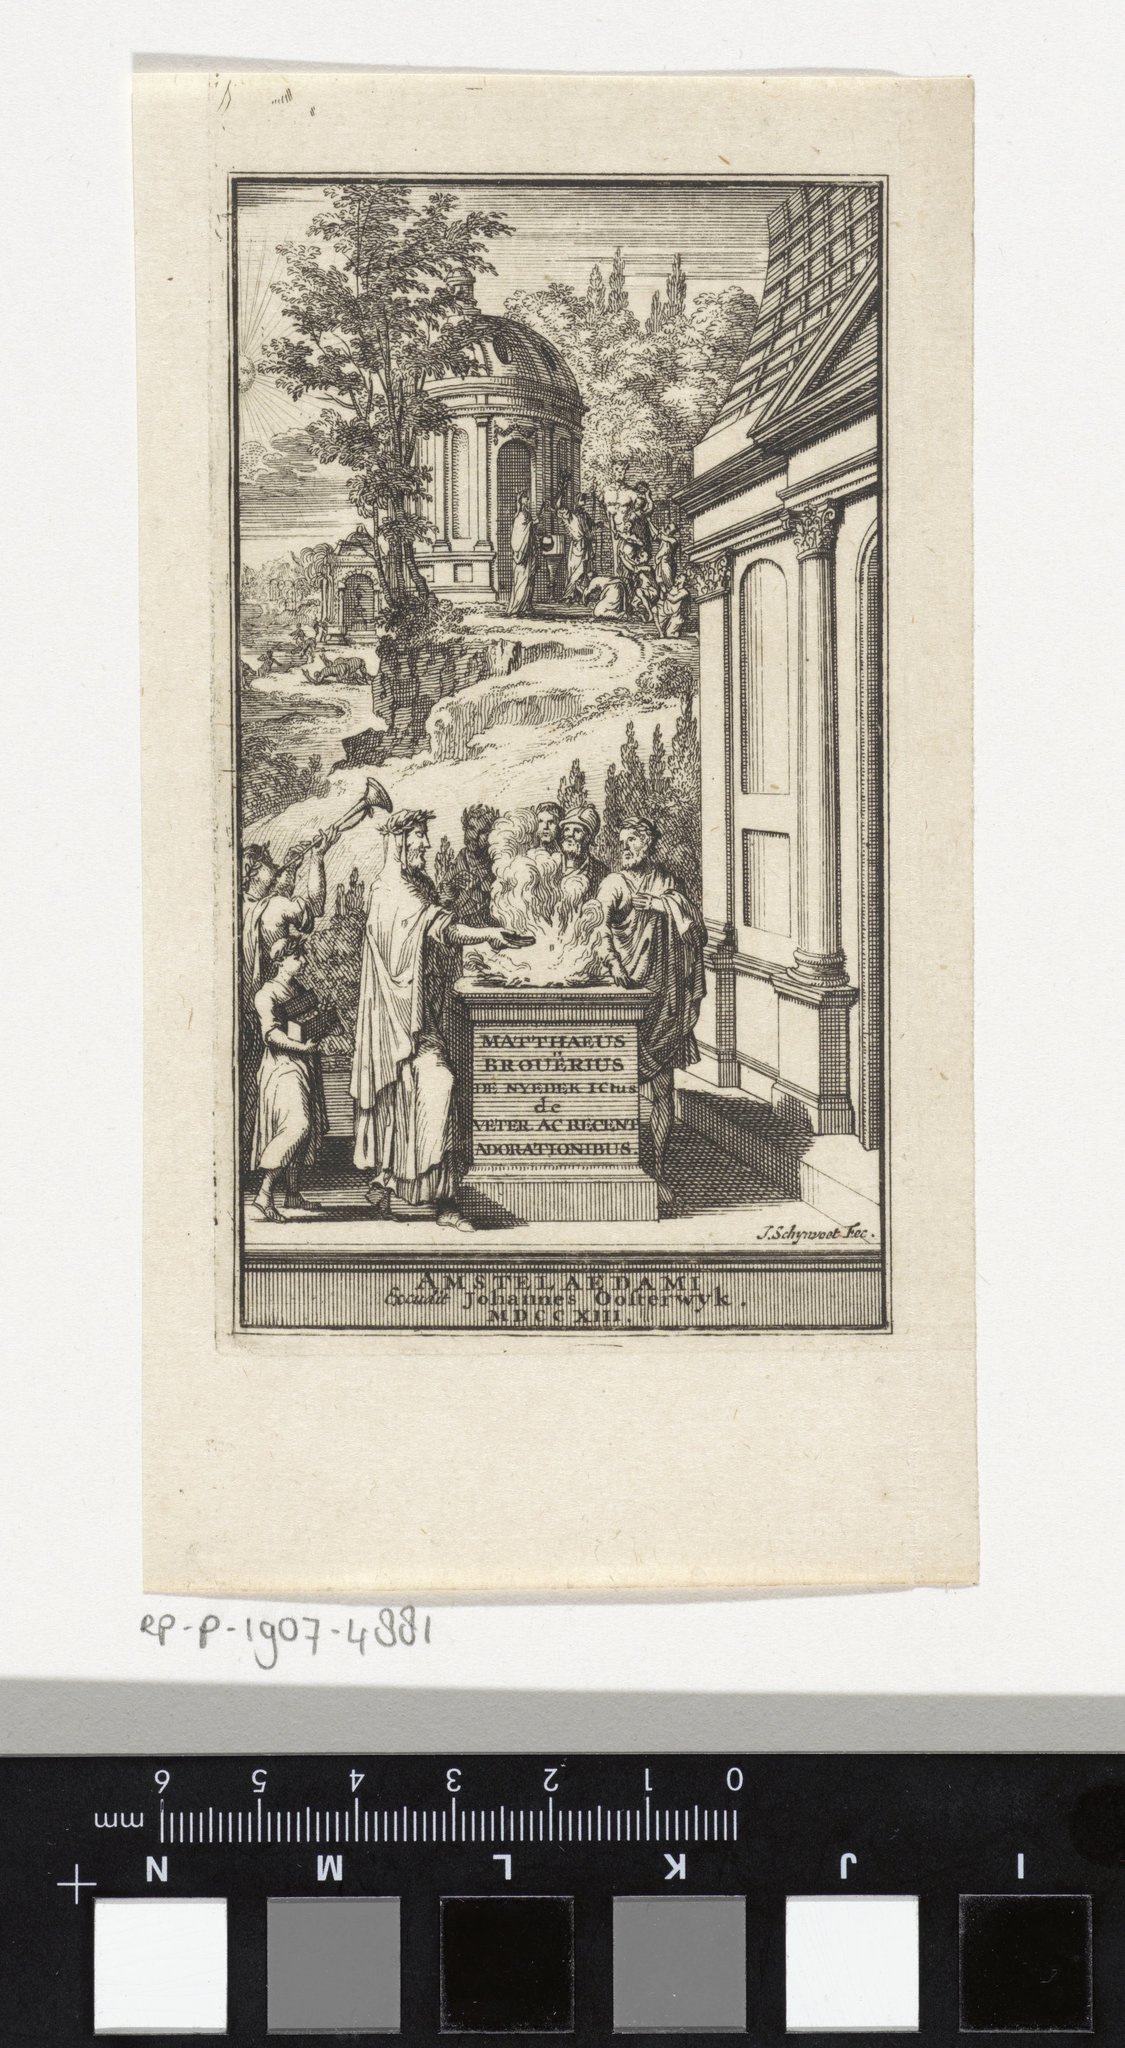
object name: titelblad, titelpagina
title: Figuren brengen offers naar een brandend altaar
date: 1713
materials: paper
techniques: etching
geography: amsterdam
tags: sacrifice ~ non-christian religions, altar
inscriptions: collector's mark: Lugt 2228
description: Titelpagina voor: Brouërius van Nidek, Matthaeus. De populorum veterum ac recentiorum adorationibus dissertatio. Amsterdam: Johannes van Oosterwyk, 1713.